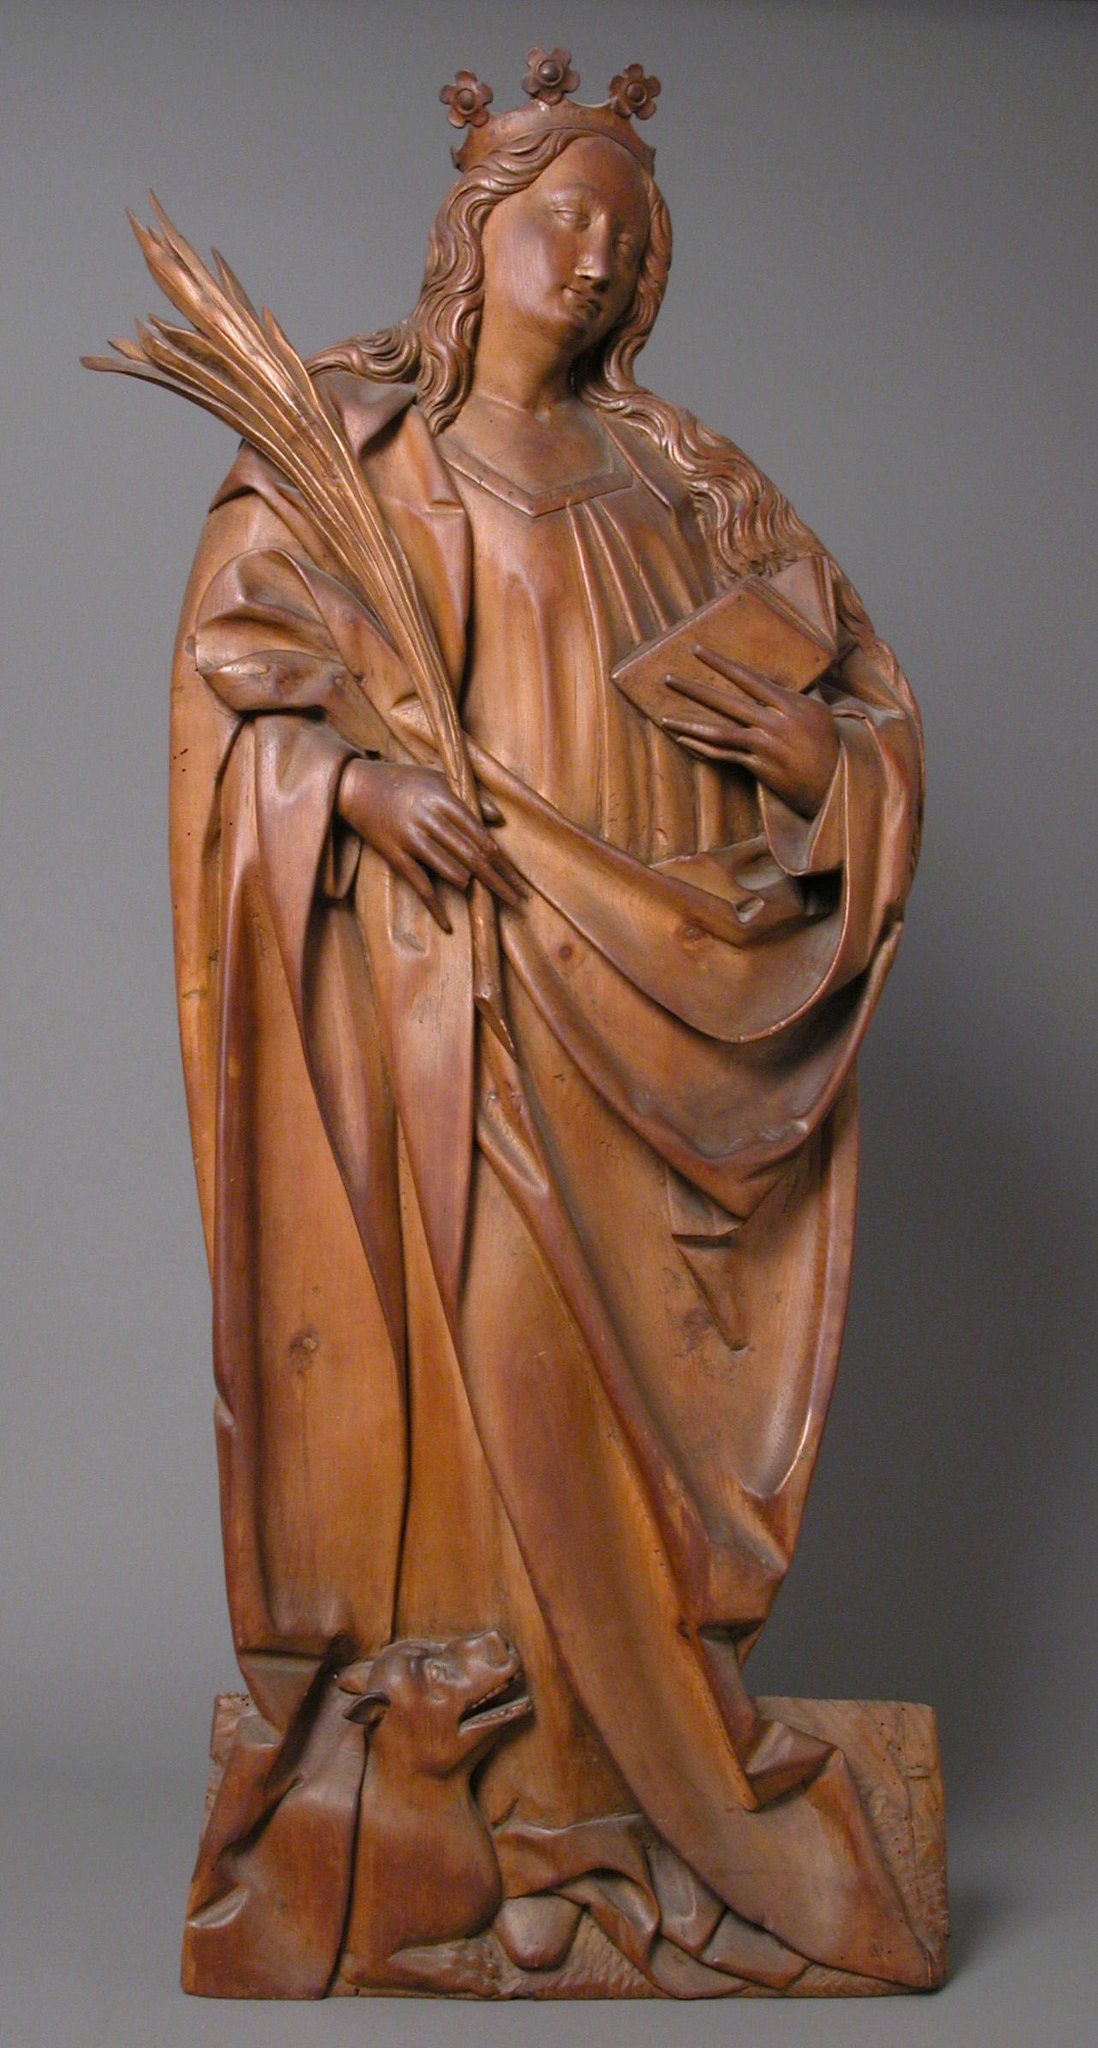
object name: relief statue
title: St. Margaret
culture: german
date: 1520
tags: saints